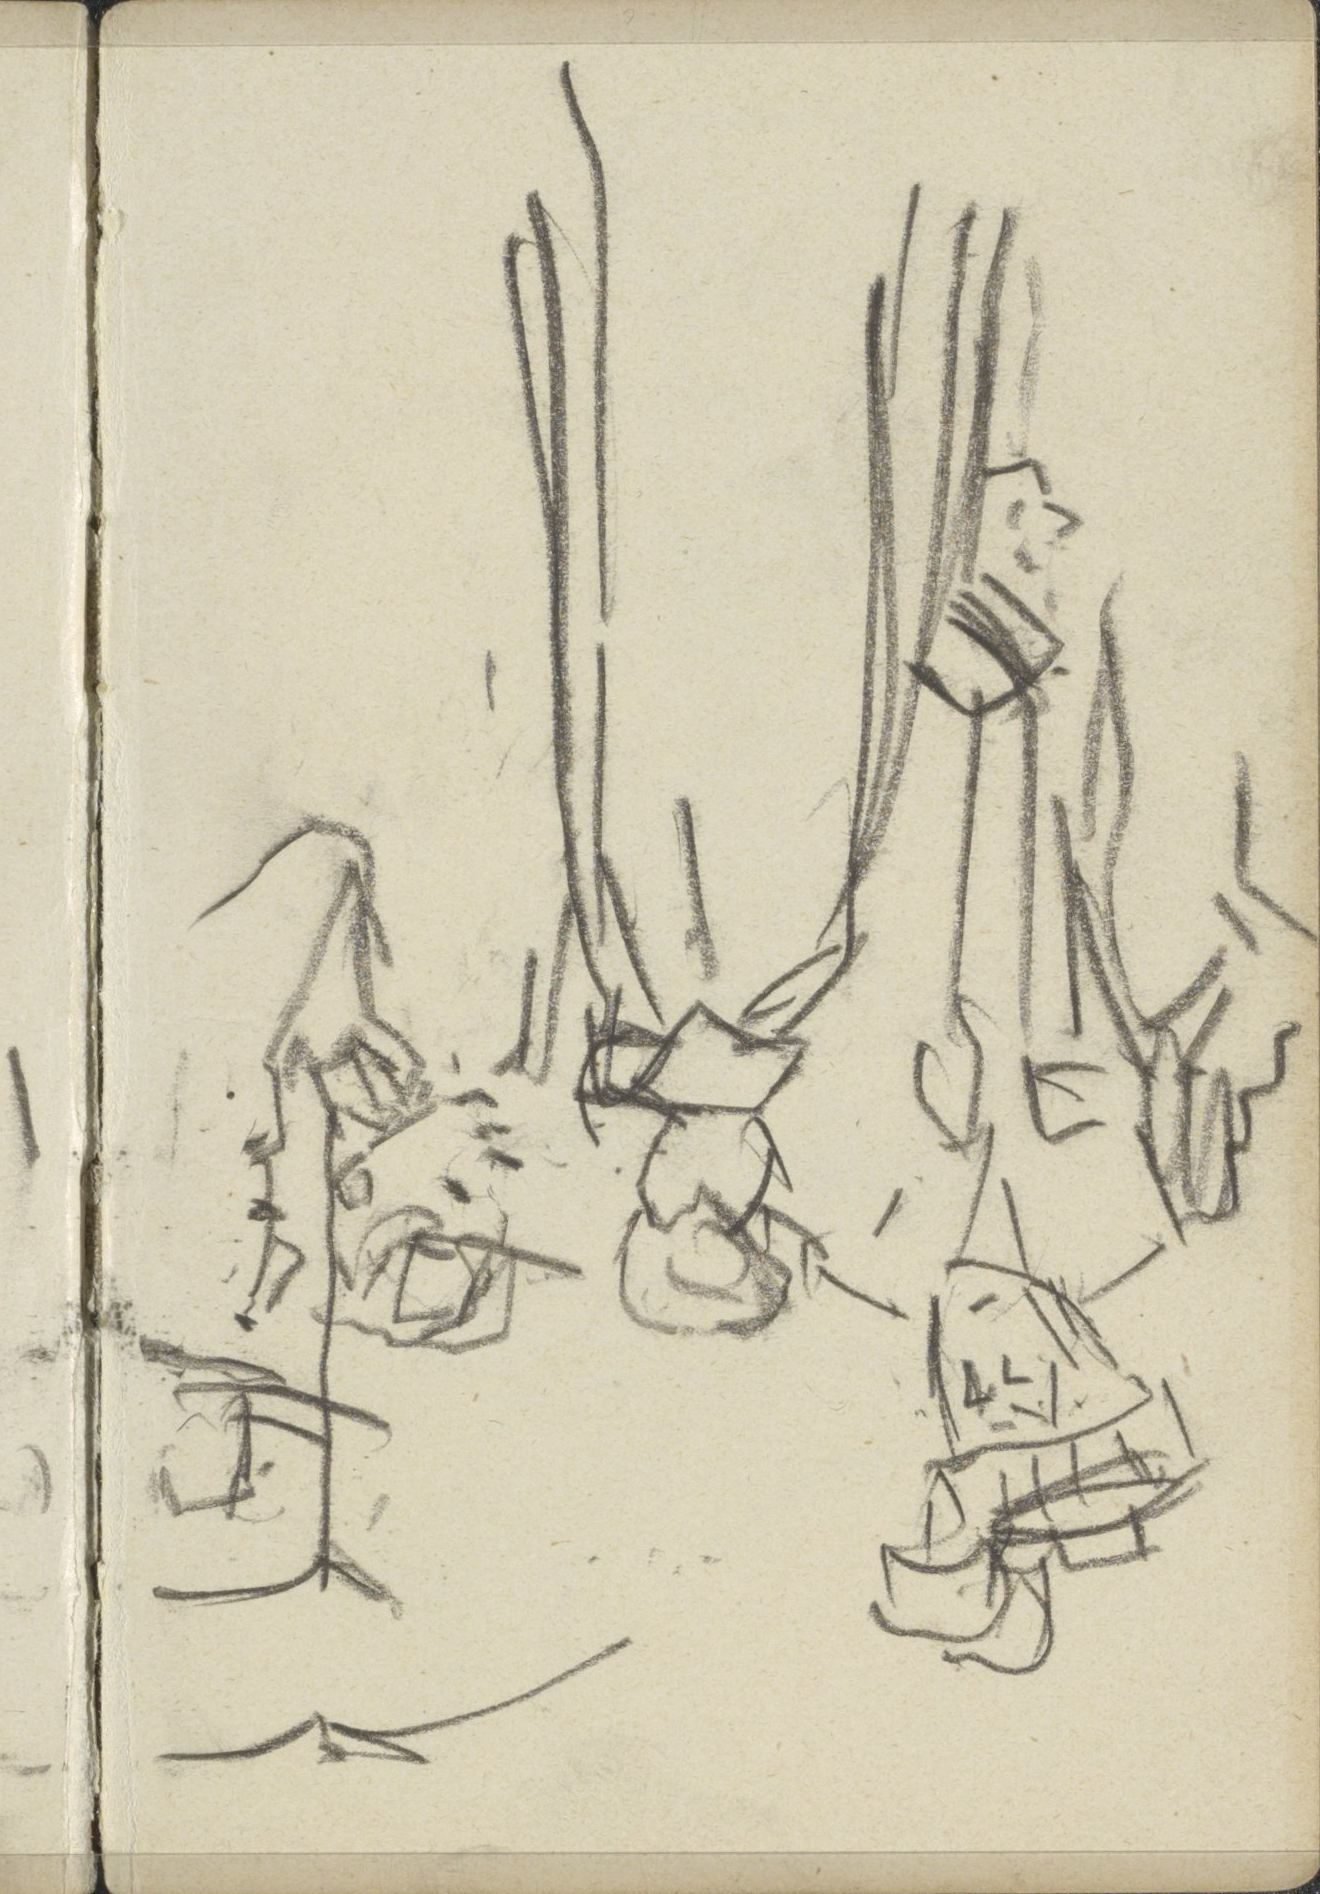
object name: sketchbook leaf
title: Staande figuren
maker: george hendrik breitner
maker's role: draughtsman, painter, print maker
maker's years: 1857-1923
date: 1910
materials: chalk, paper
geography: amsterdam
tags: standing figure, adult woman, adult man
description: Figuurstudies. Pagina 70 uit een schetsboek met 45 bladen.